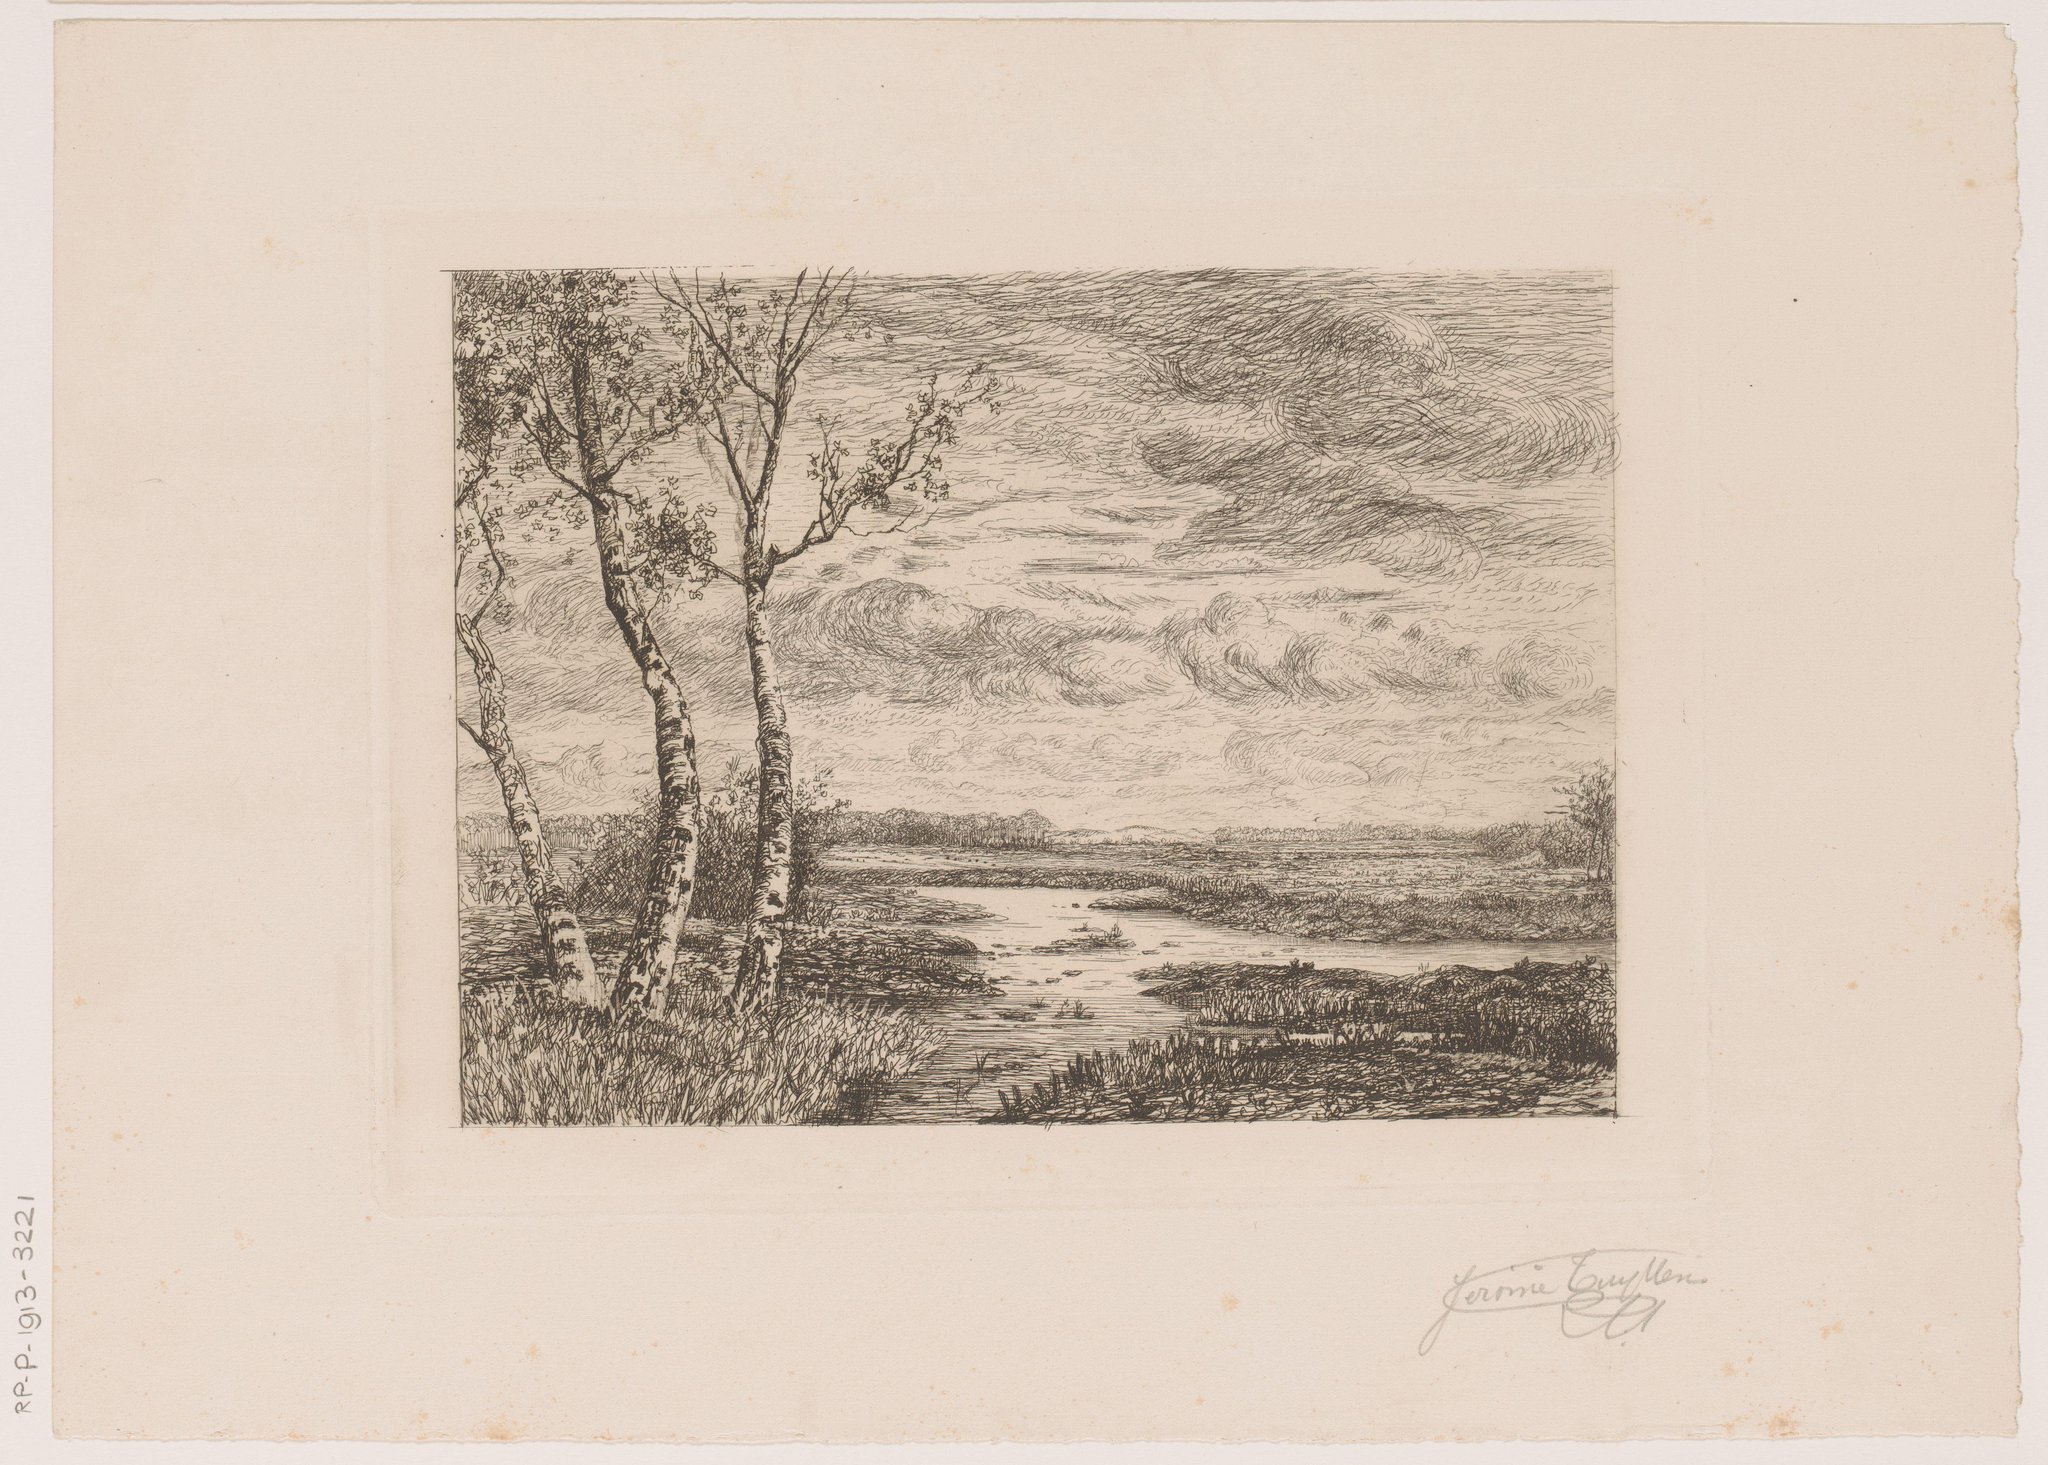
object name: print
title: Landschap met drie berken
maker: jerôme tuyttens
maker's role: painter, print maker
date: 1850-1883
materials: paper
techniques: drypoint, etching, intaglio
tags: water course, trees: birch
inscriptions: collector's mark: Lugt 2228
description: Sterfdatum van de prentmaker is onbekend. Daarom is voor de bepaling van de rechten van dit object gebruik gemaakt van de verwervingsdatum Rijksmuseum Amsterdam.